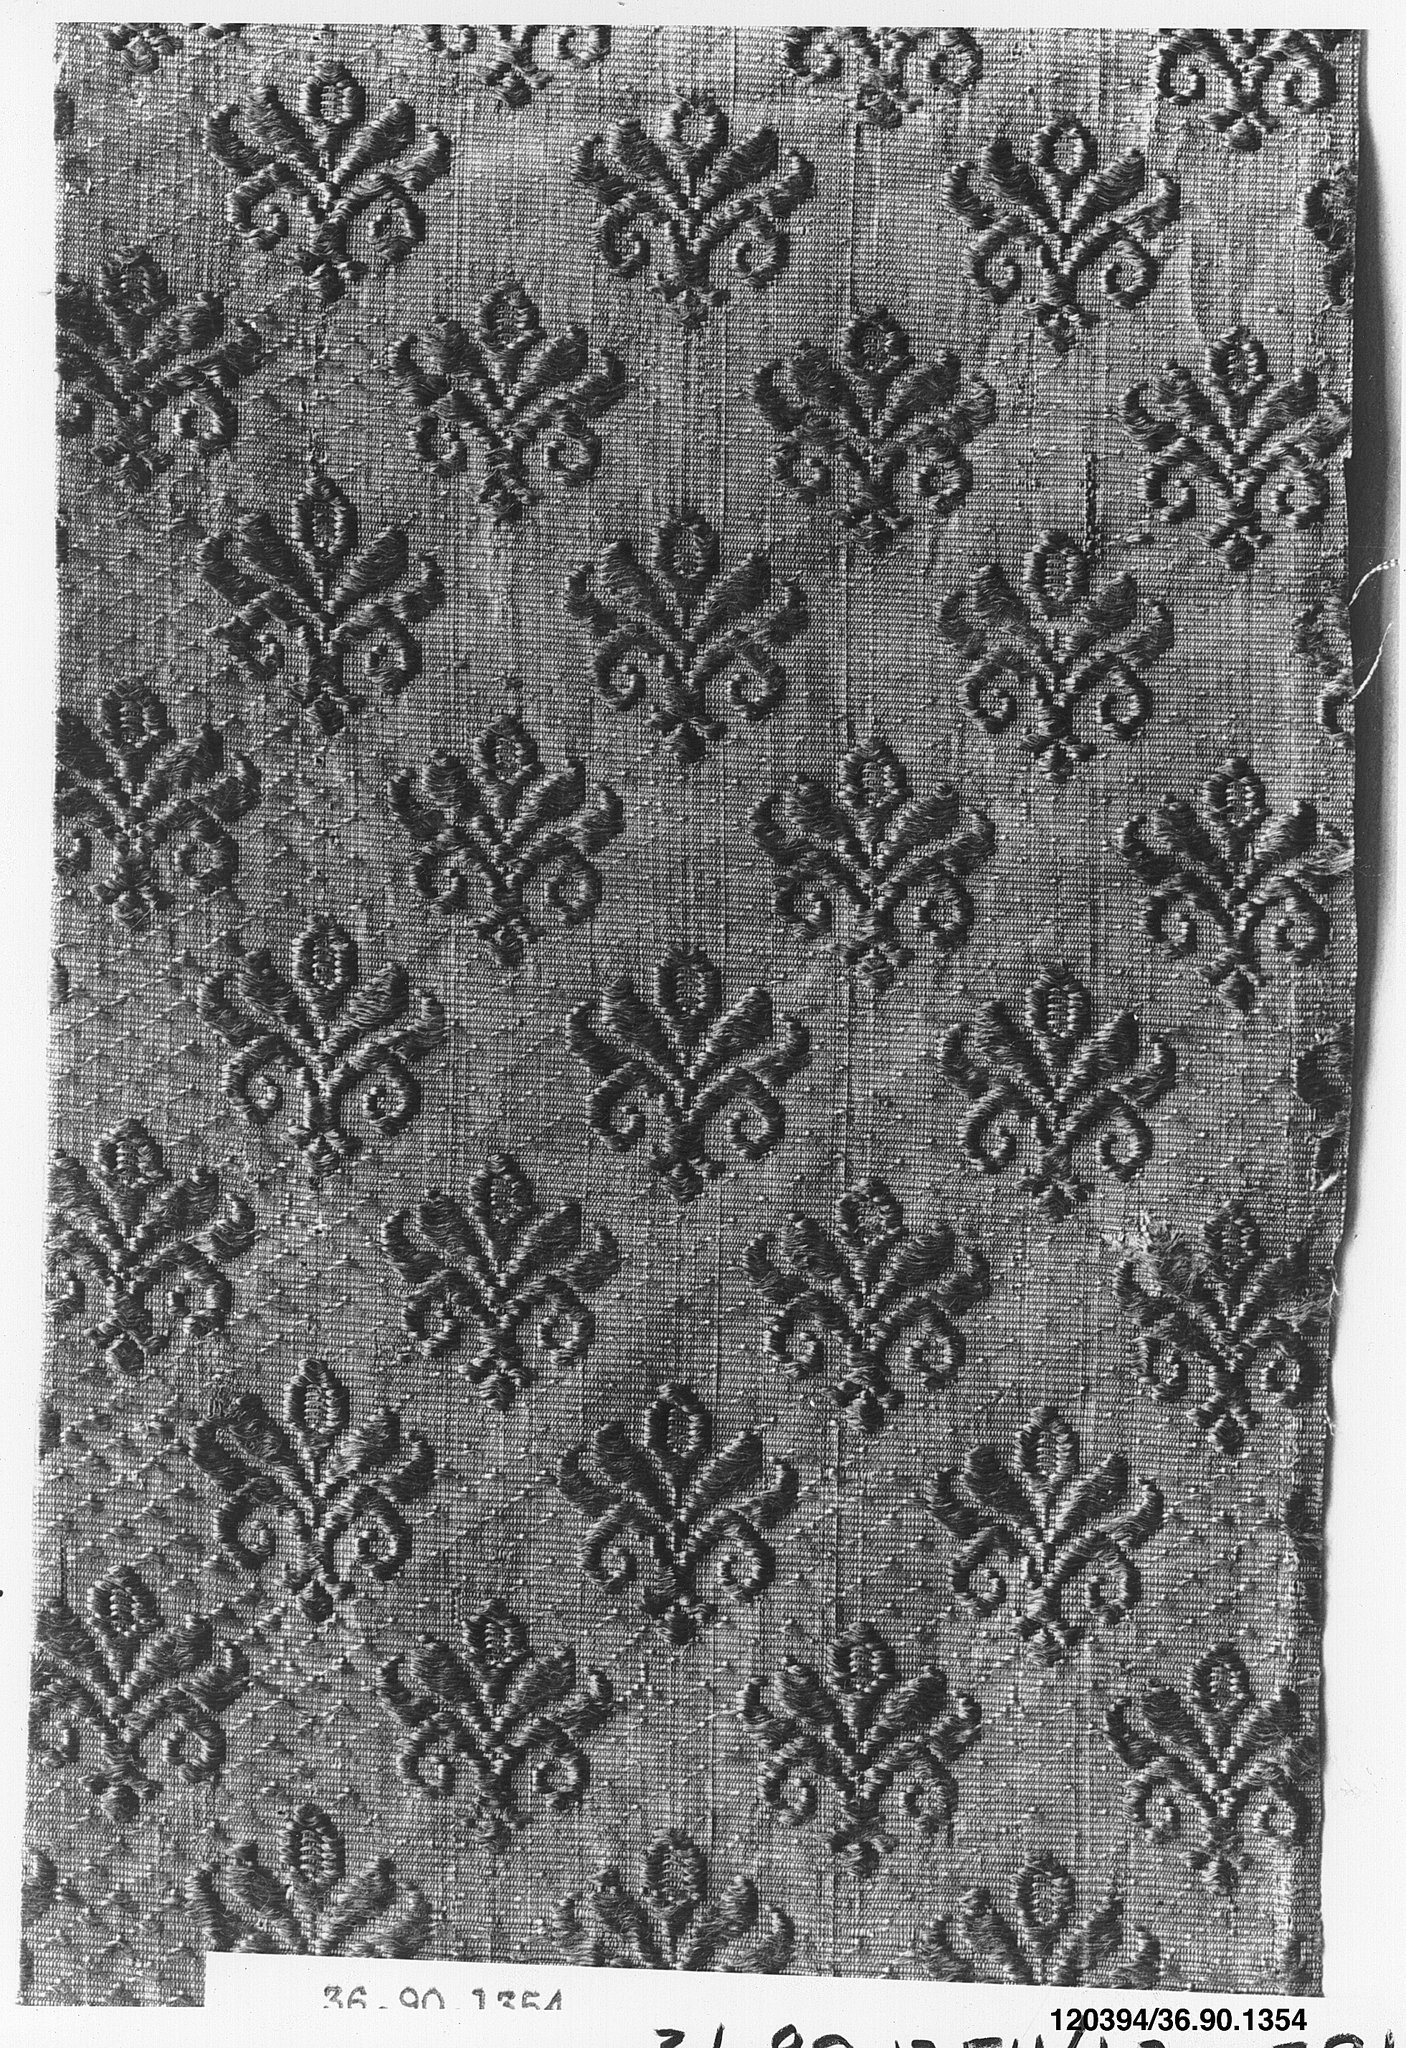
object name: piece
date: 1501-1700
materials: silk